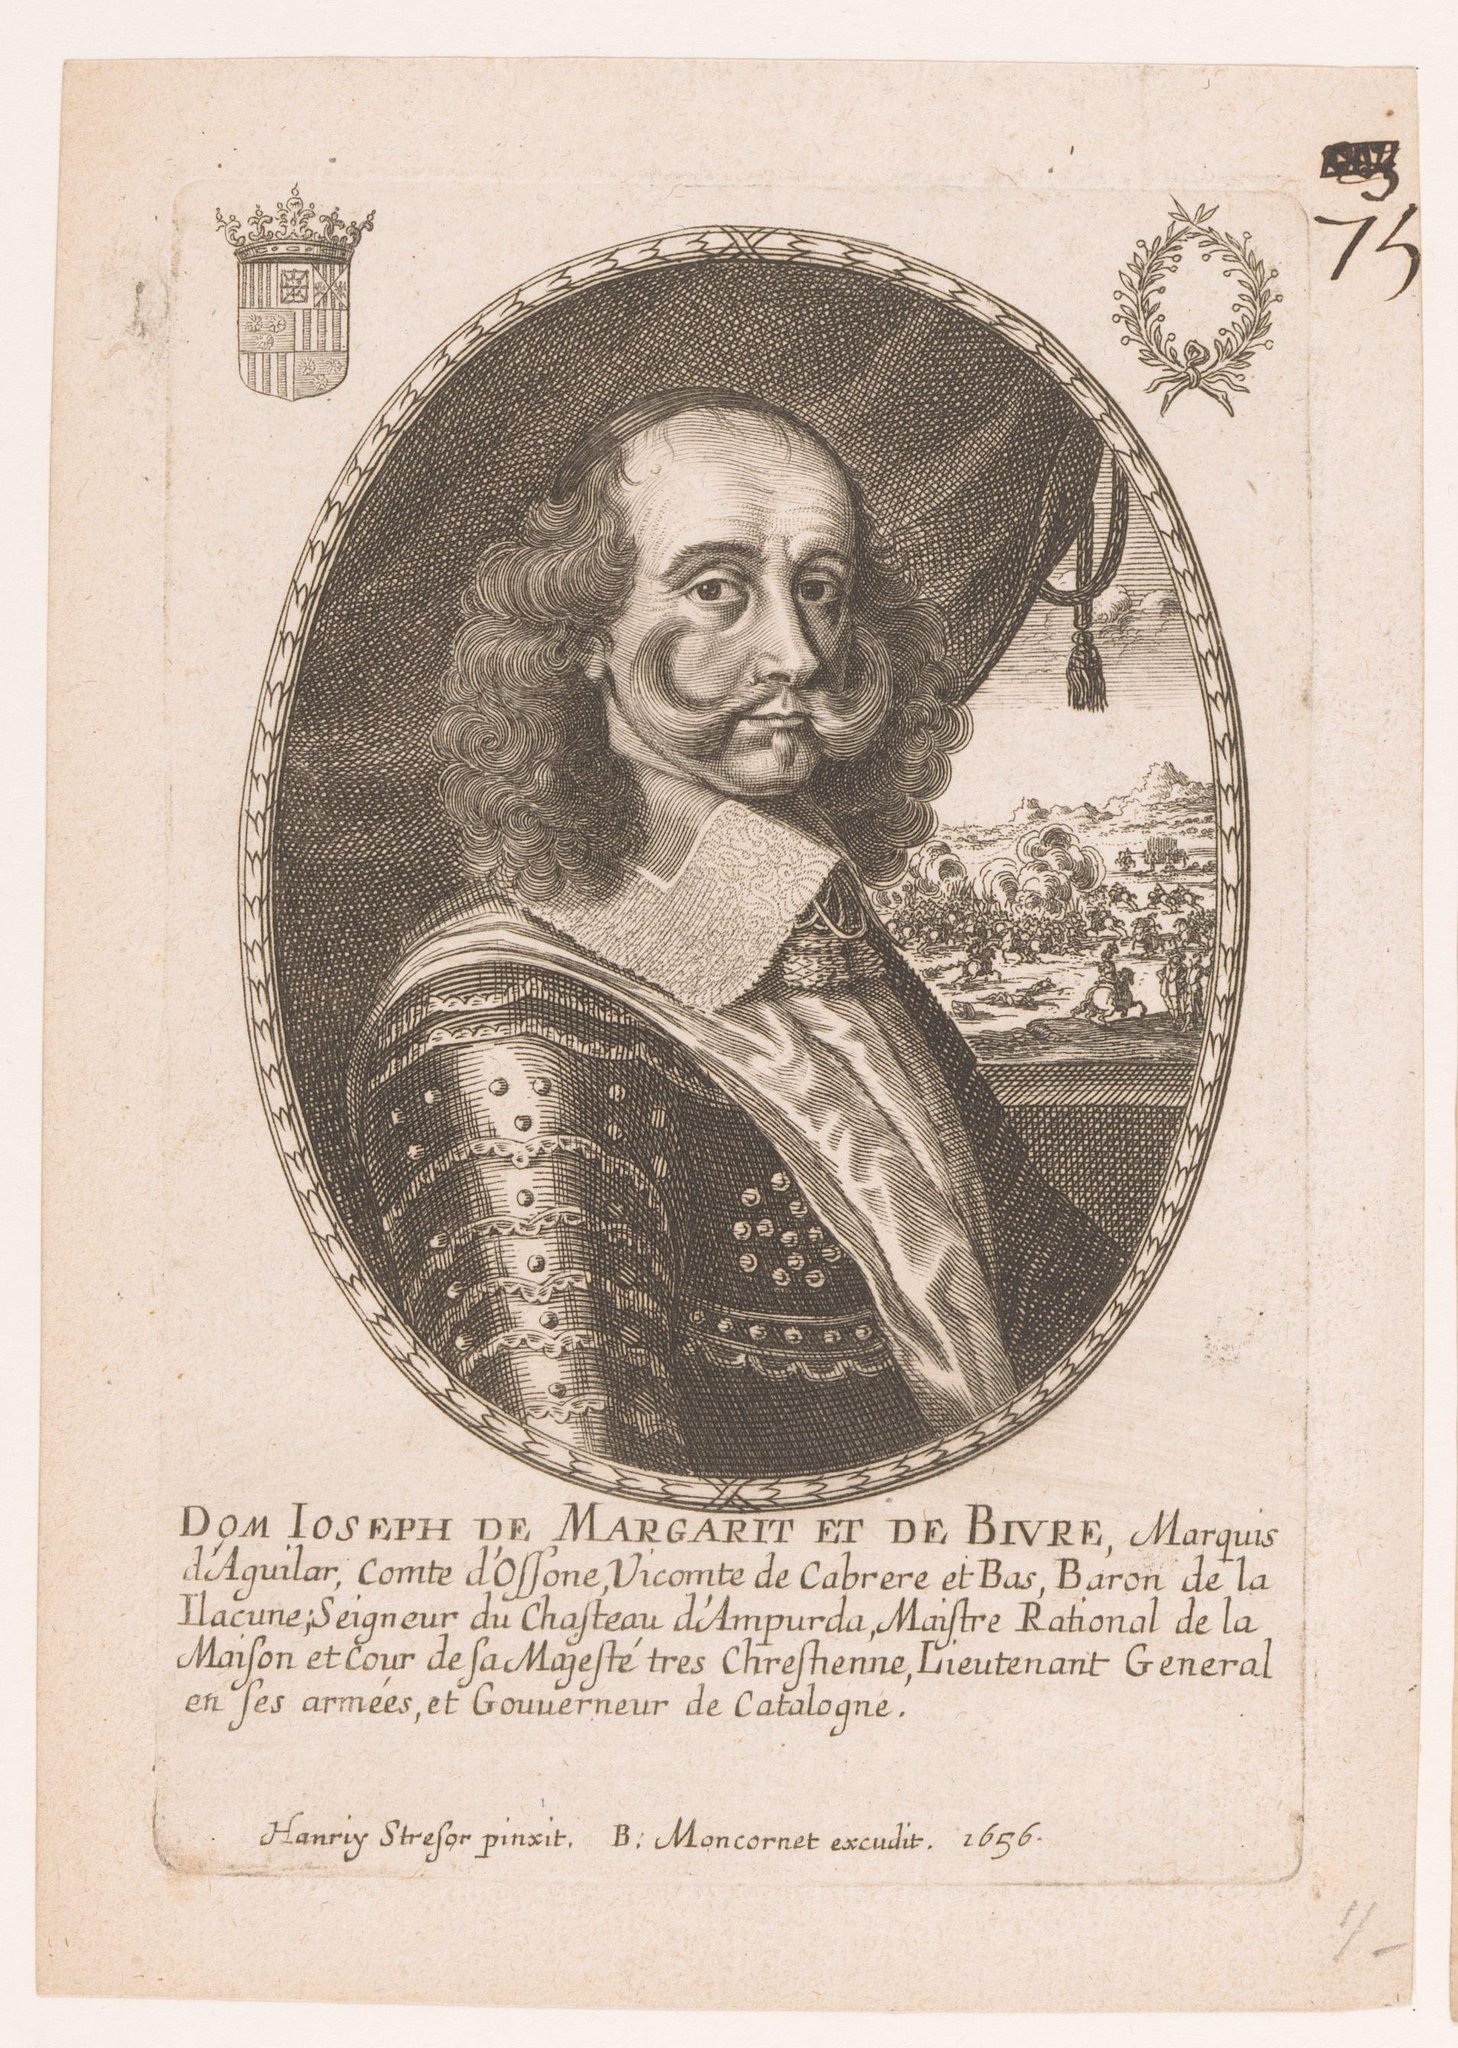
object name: print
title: Portret van Joseph de Margarit de Biure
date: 1656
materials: paper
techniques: engraving, etching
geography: paris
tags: commander-in-chief, general, marshal, historical persons, armorial bearing, heraldry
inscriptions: number: ‘75’, collector's mark: Lugt 2228